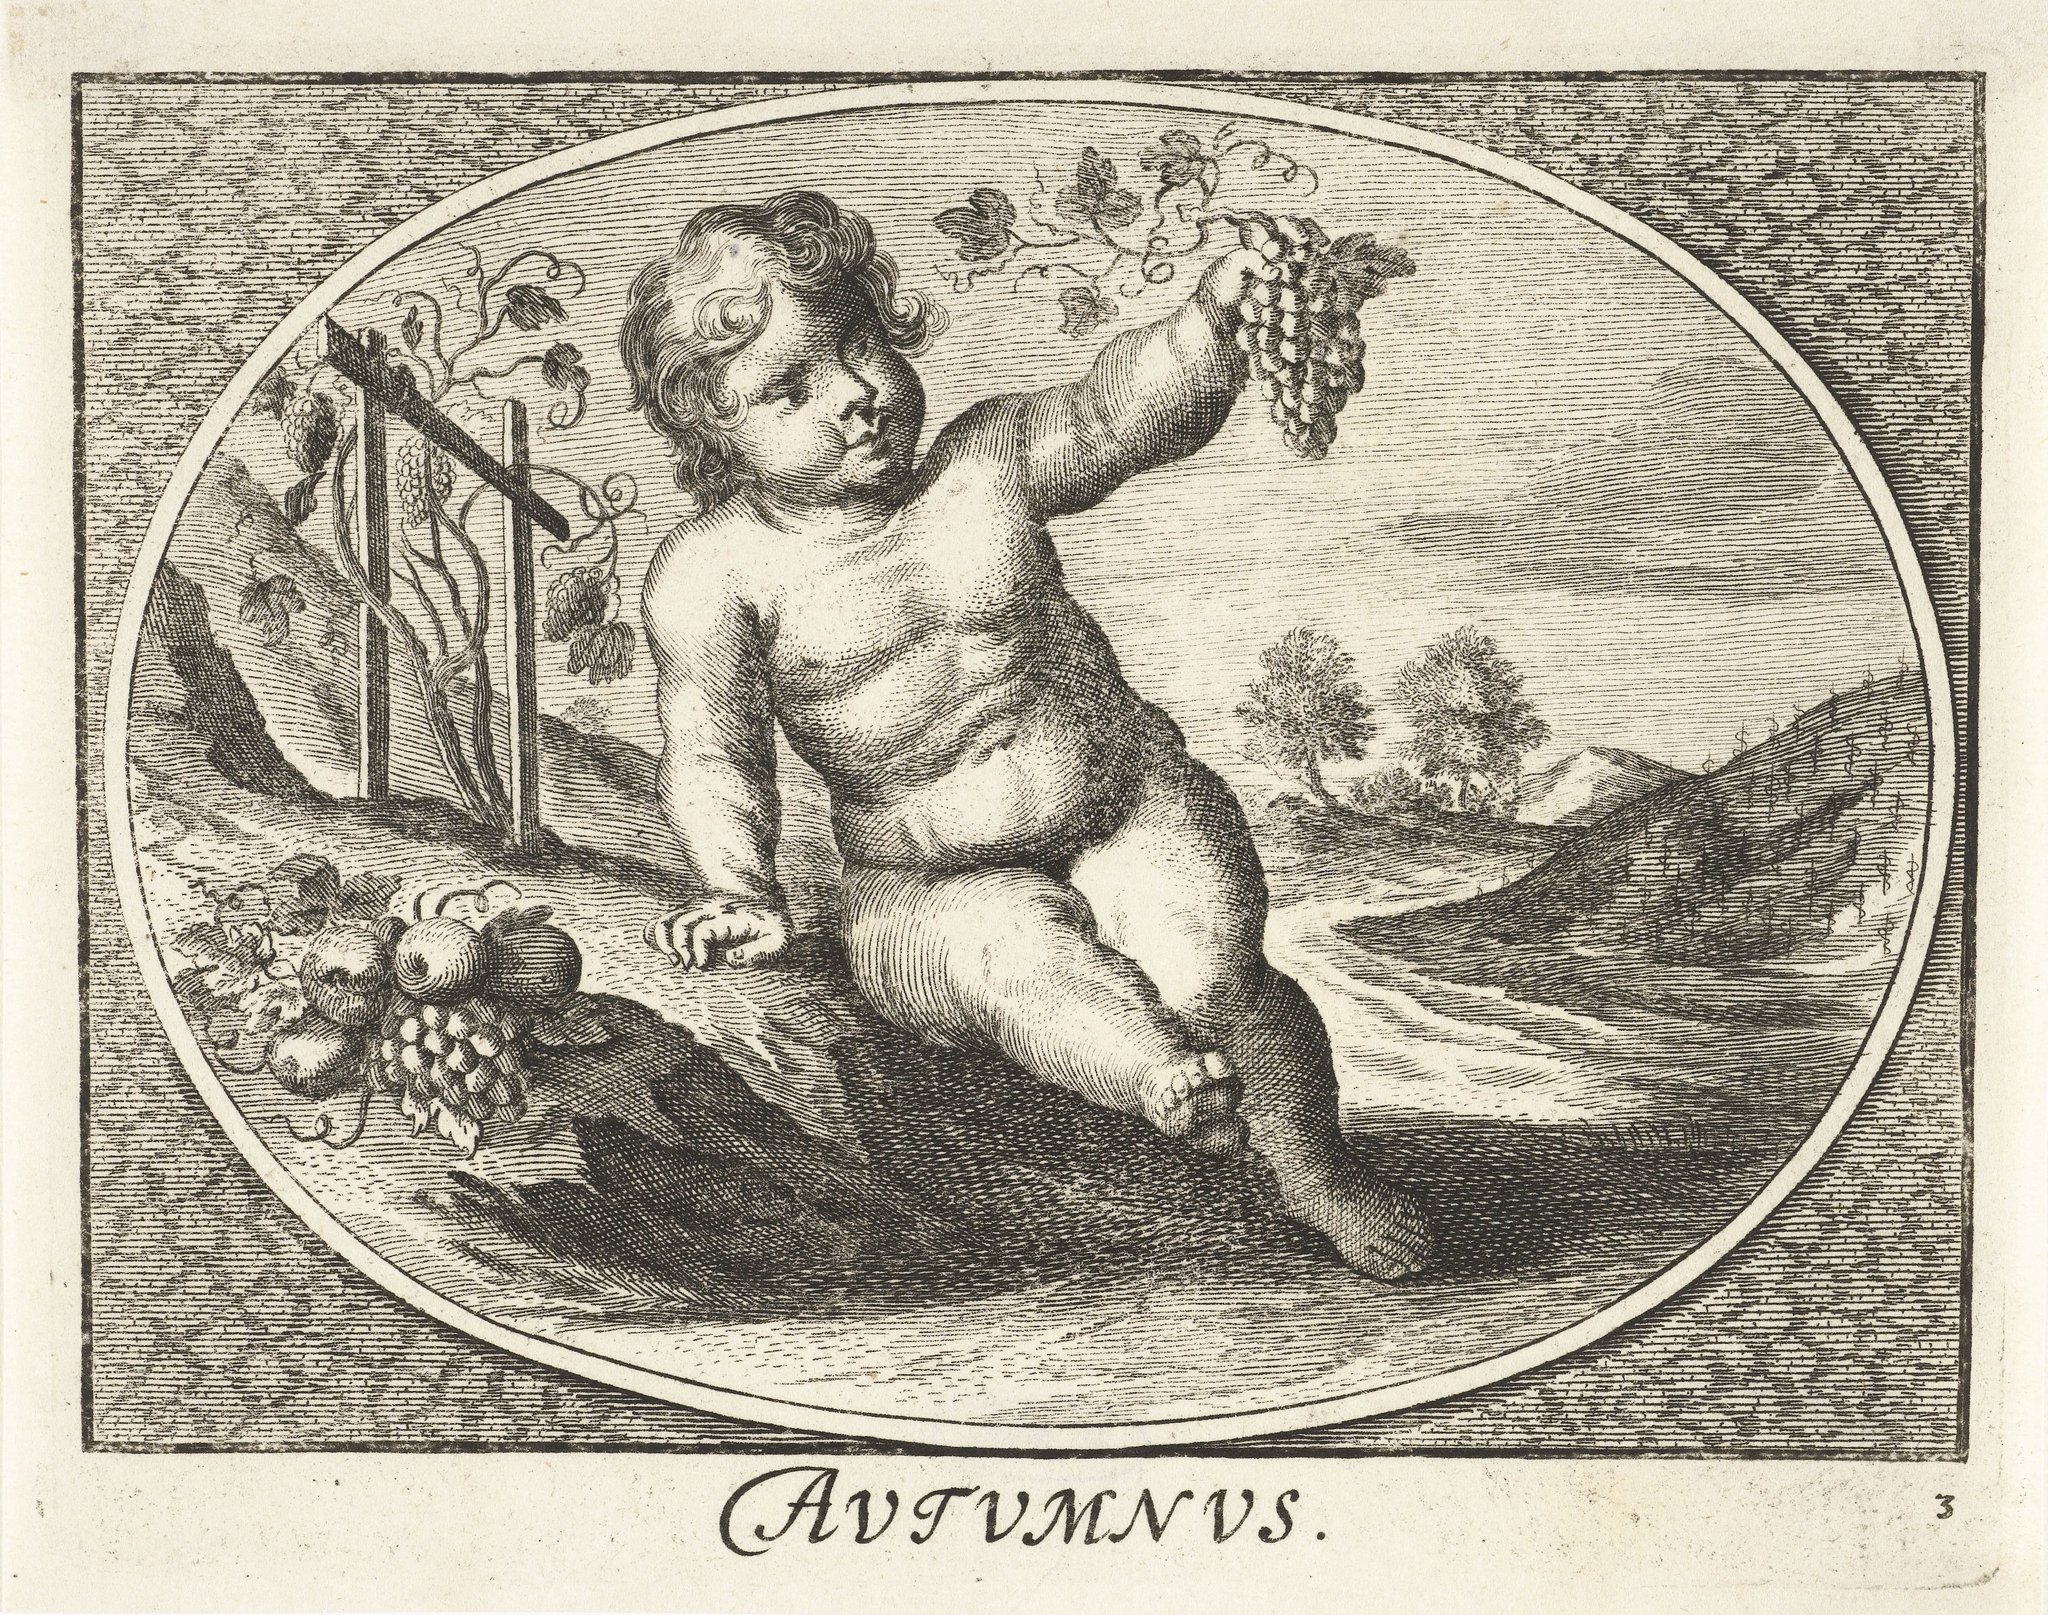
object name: print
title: Vier jaargetijden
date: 1735-1750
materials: paper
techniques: engraving, etching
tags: autumn, fall, 'autumnus'; 'autunno' (ripa)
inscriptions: collector's mark: Lugt 2228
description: Kopie naar prent van Cornelis van Dalen (II) uit serie van vier prenten met de vier jaargetijden.